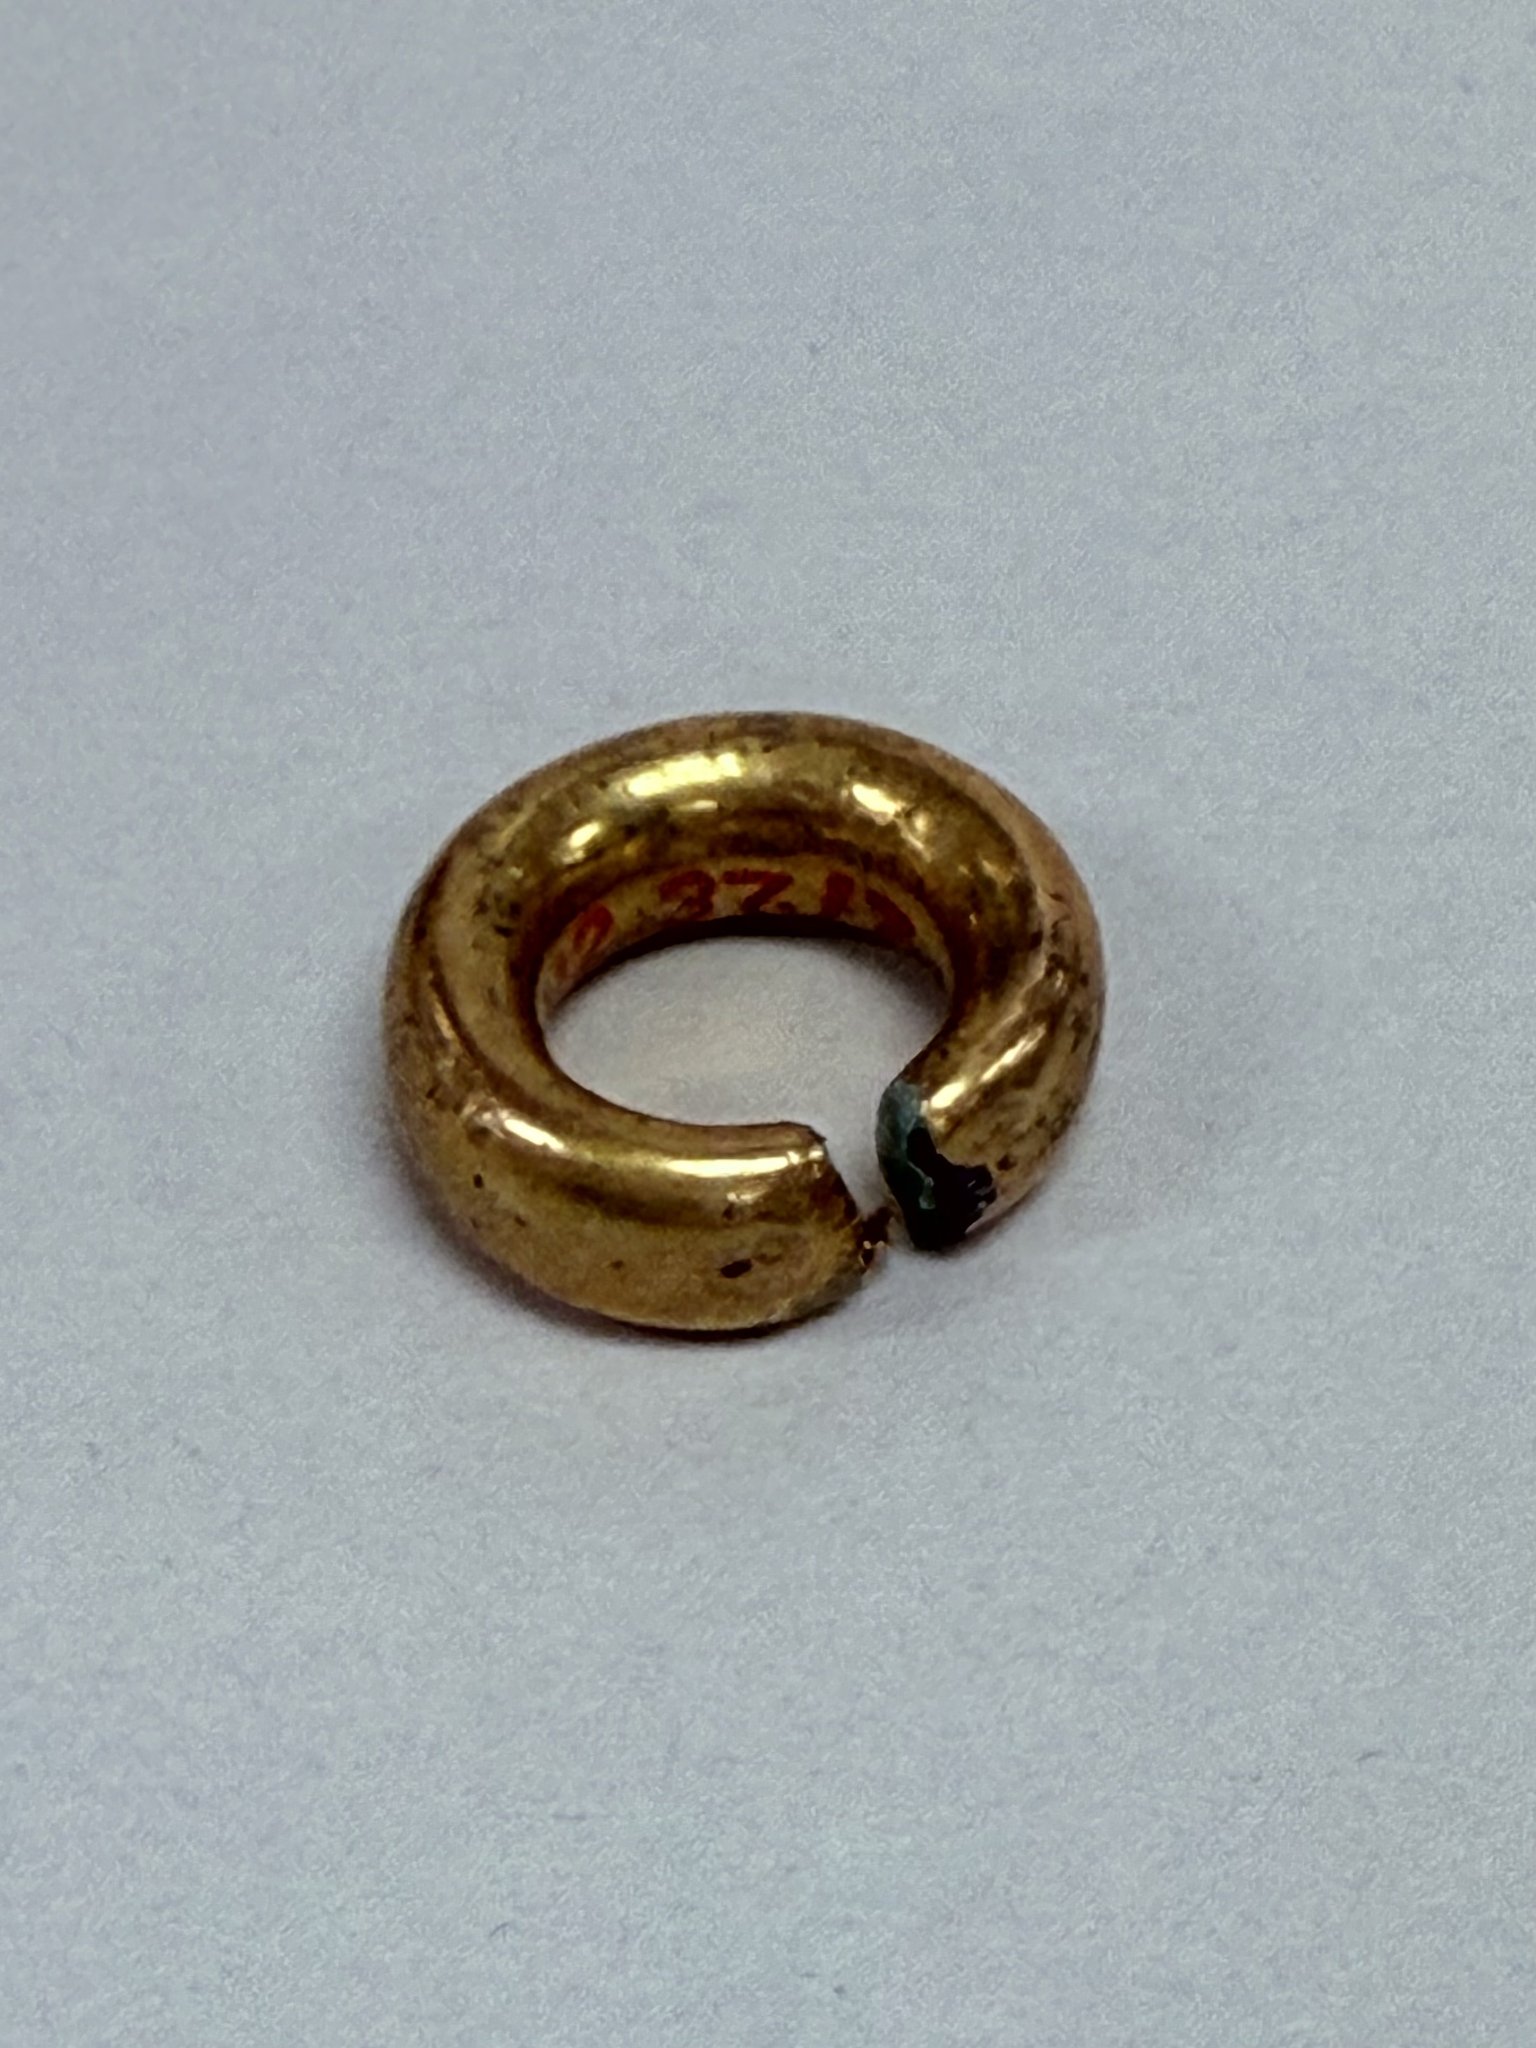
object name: earring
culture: japanese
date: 601-700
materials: gold